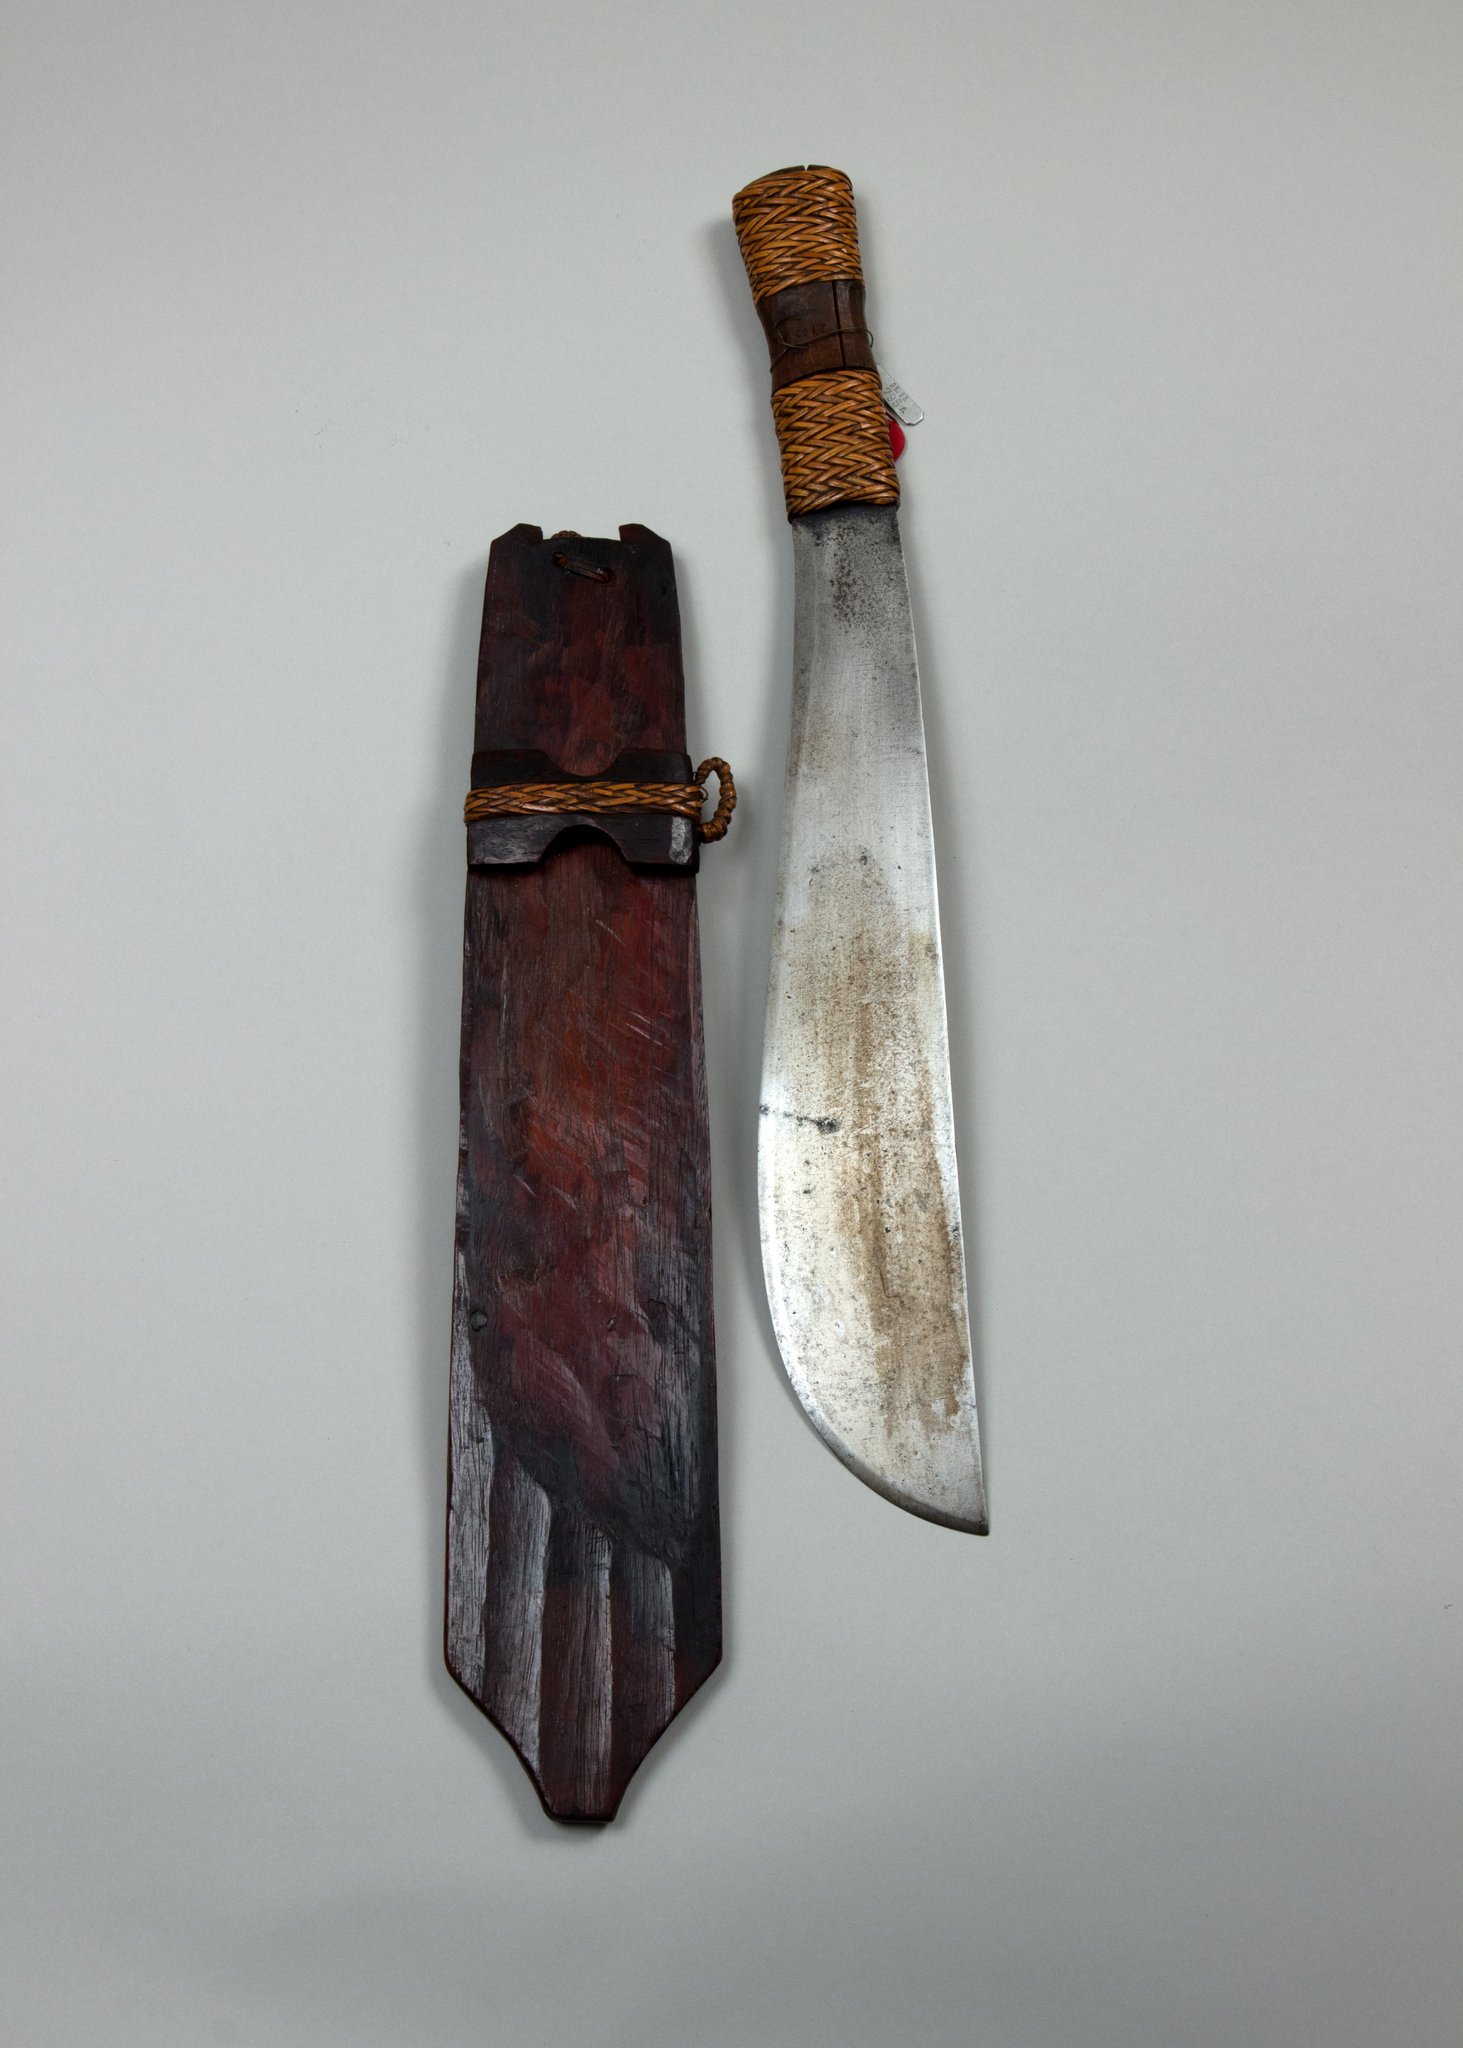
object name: knife with sheath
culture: philippine, bagobo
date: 1701-1900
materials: steel, wood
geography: philippines